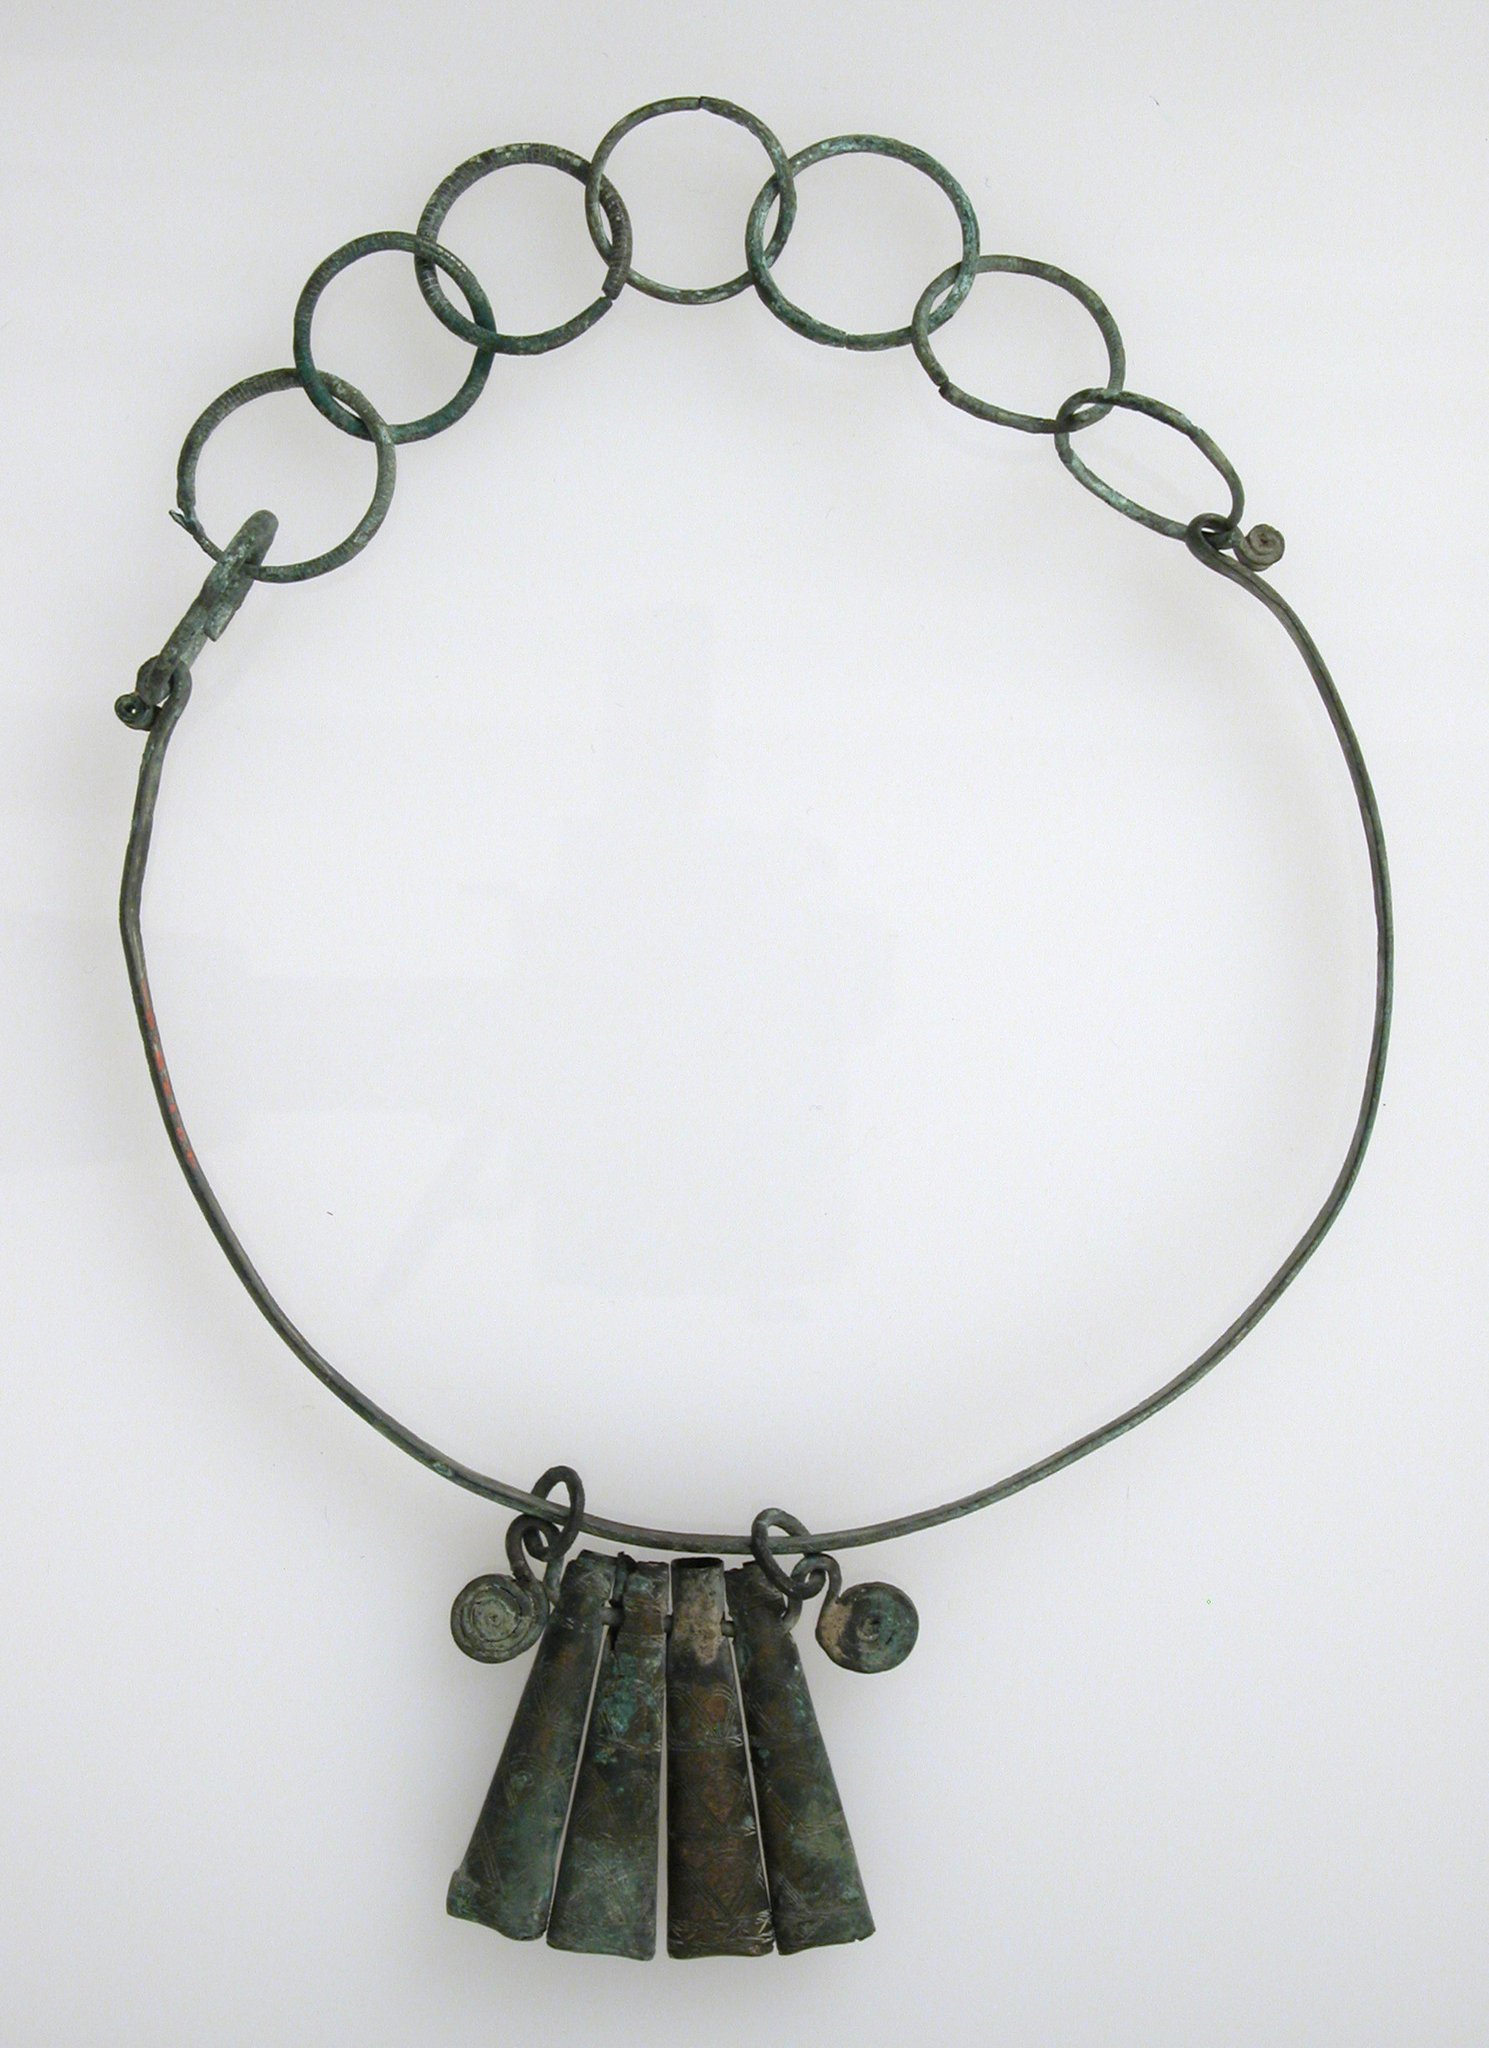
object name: necklace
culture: irish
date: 1000 BCE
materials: copper alloy